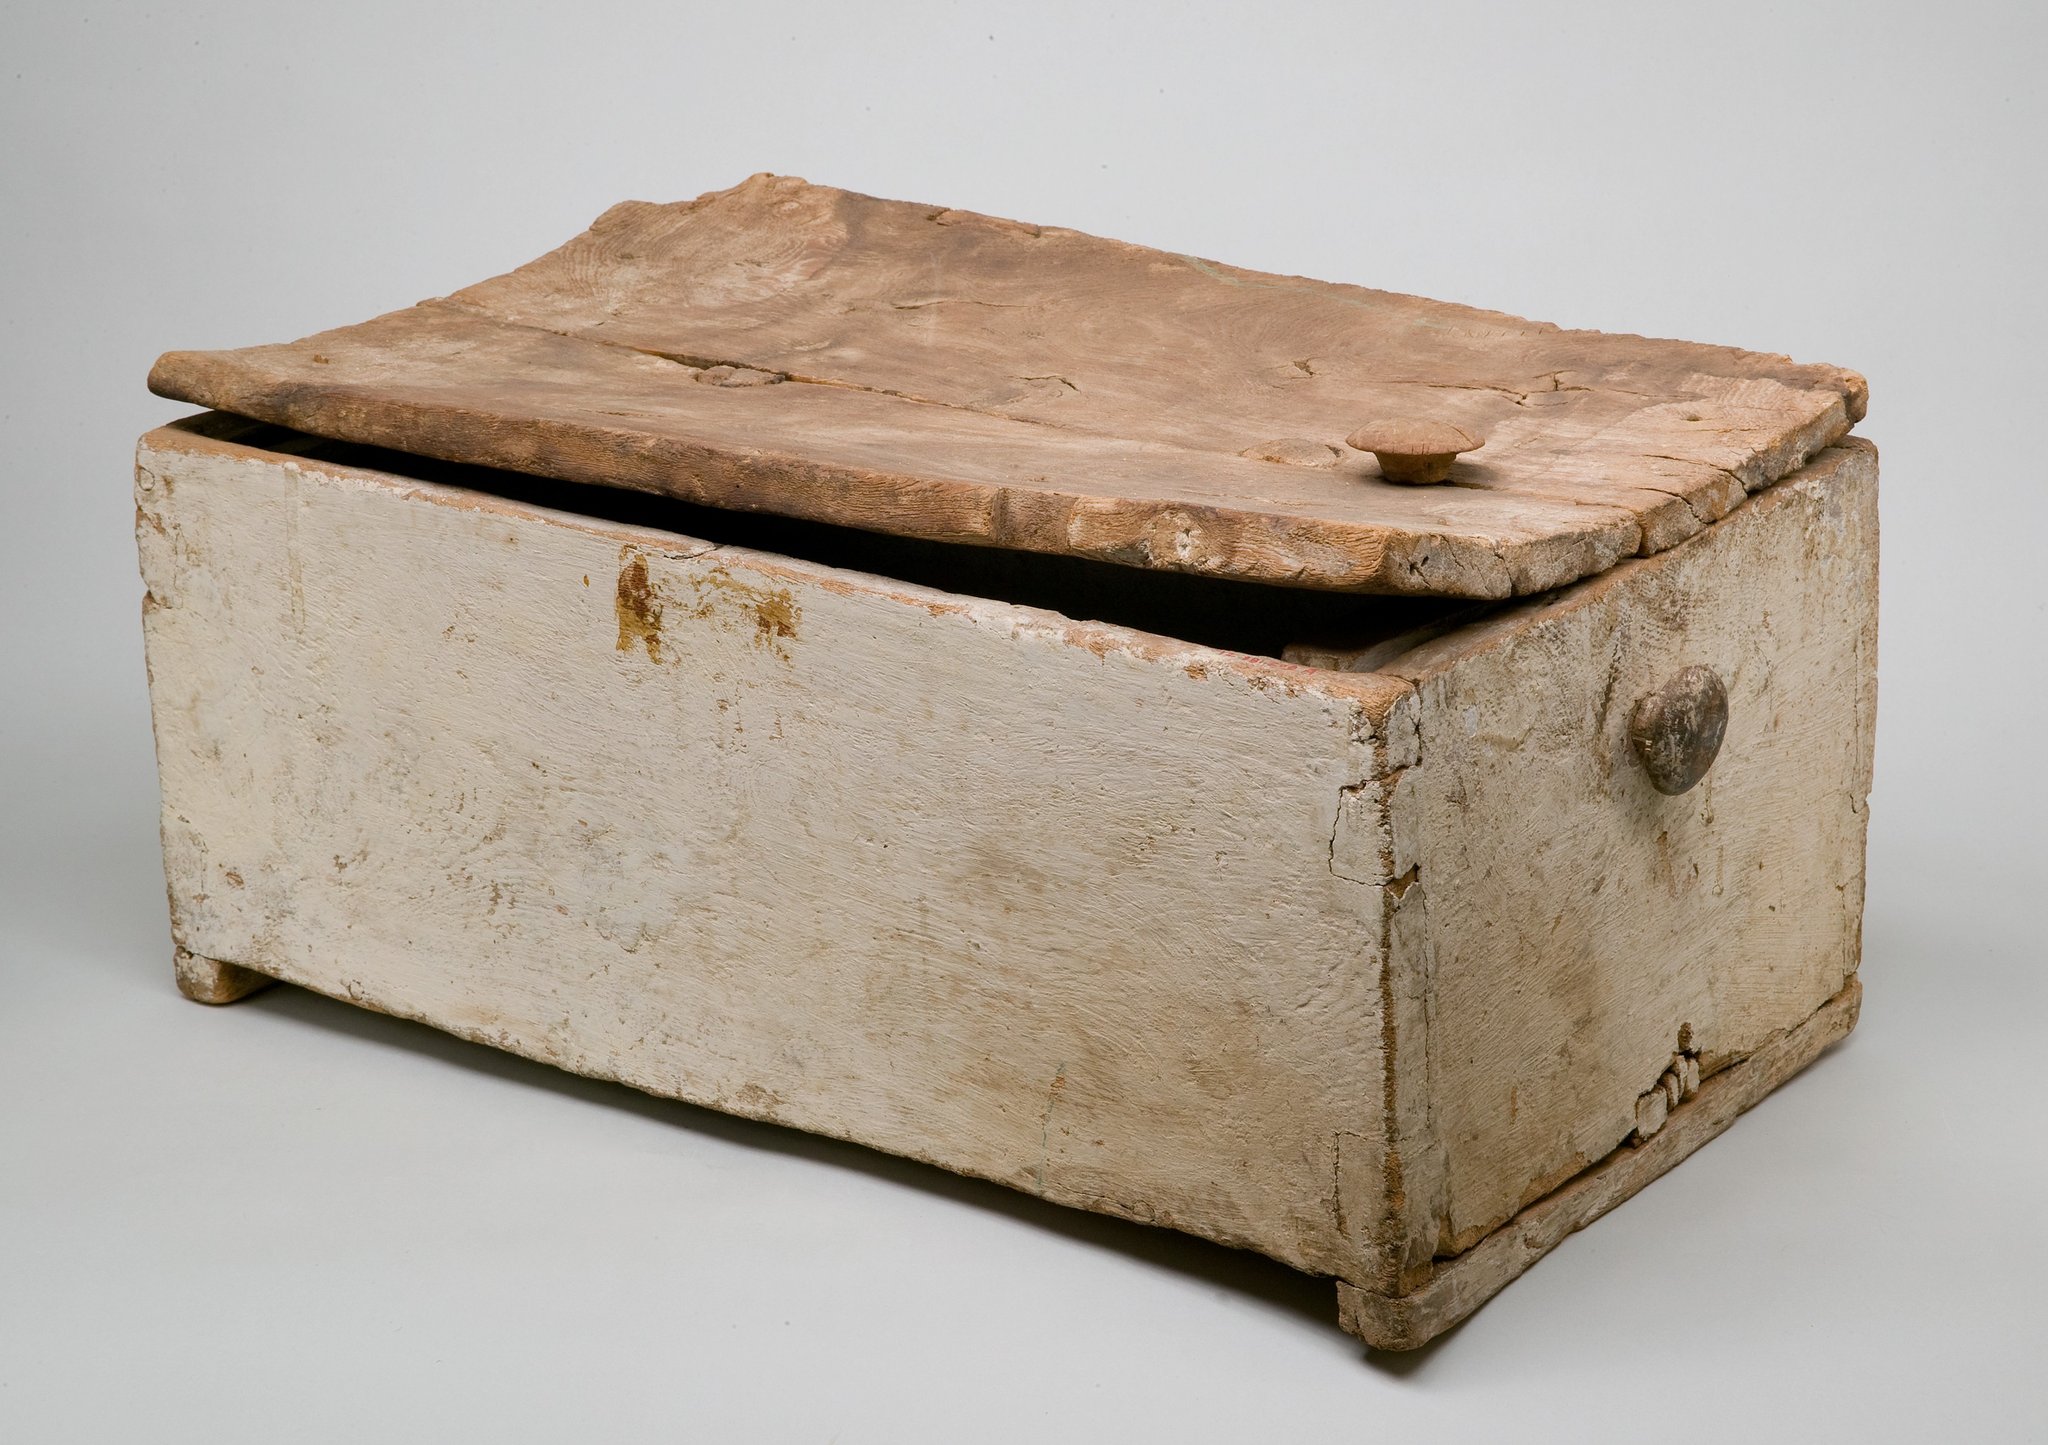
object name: coffin, child's linen chest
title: Linen Chest Reused as a Child's Coffin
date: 1479-1400 BCE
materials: wood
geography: egypt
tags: coffins